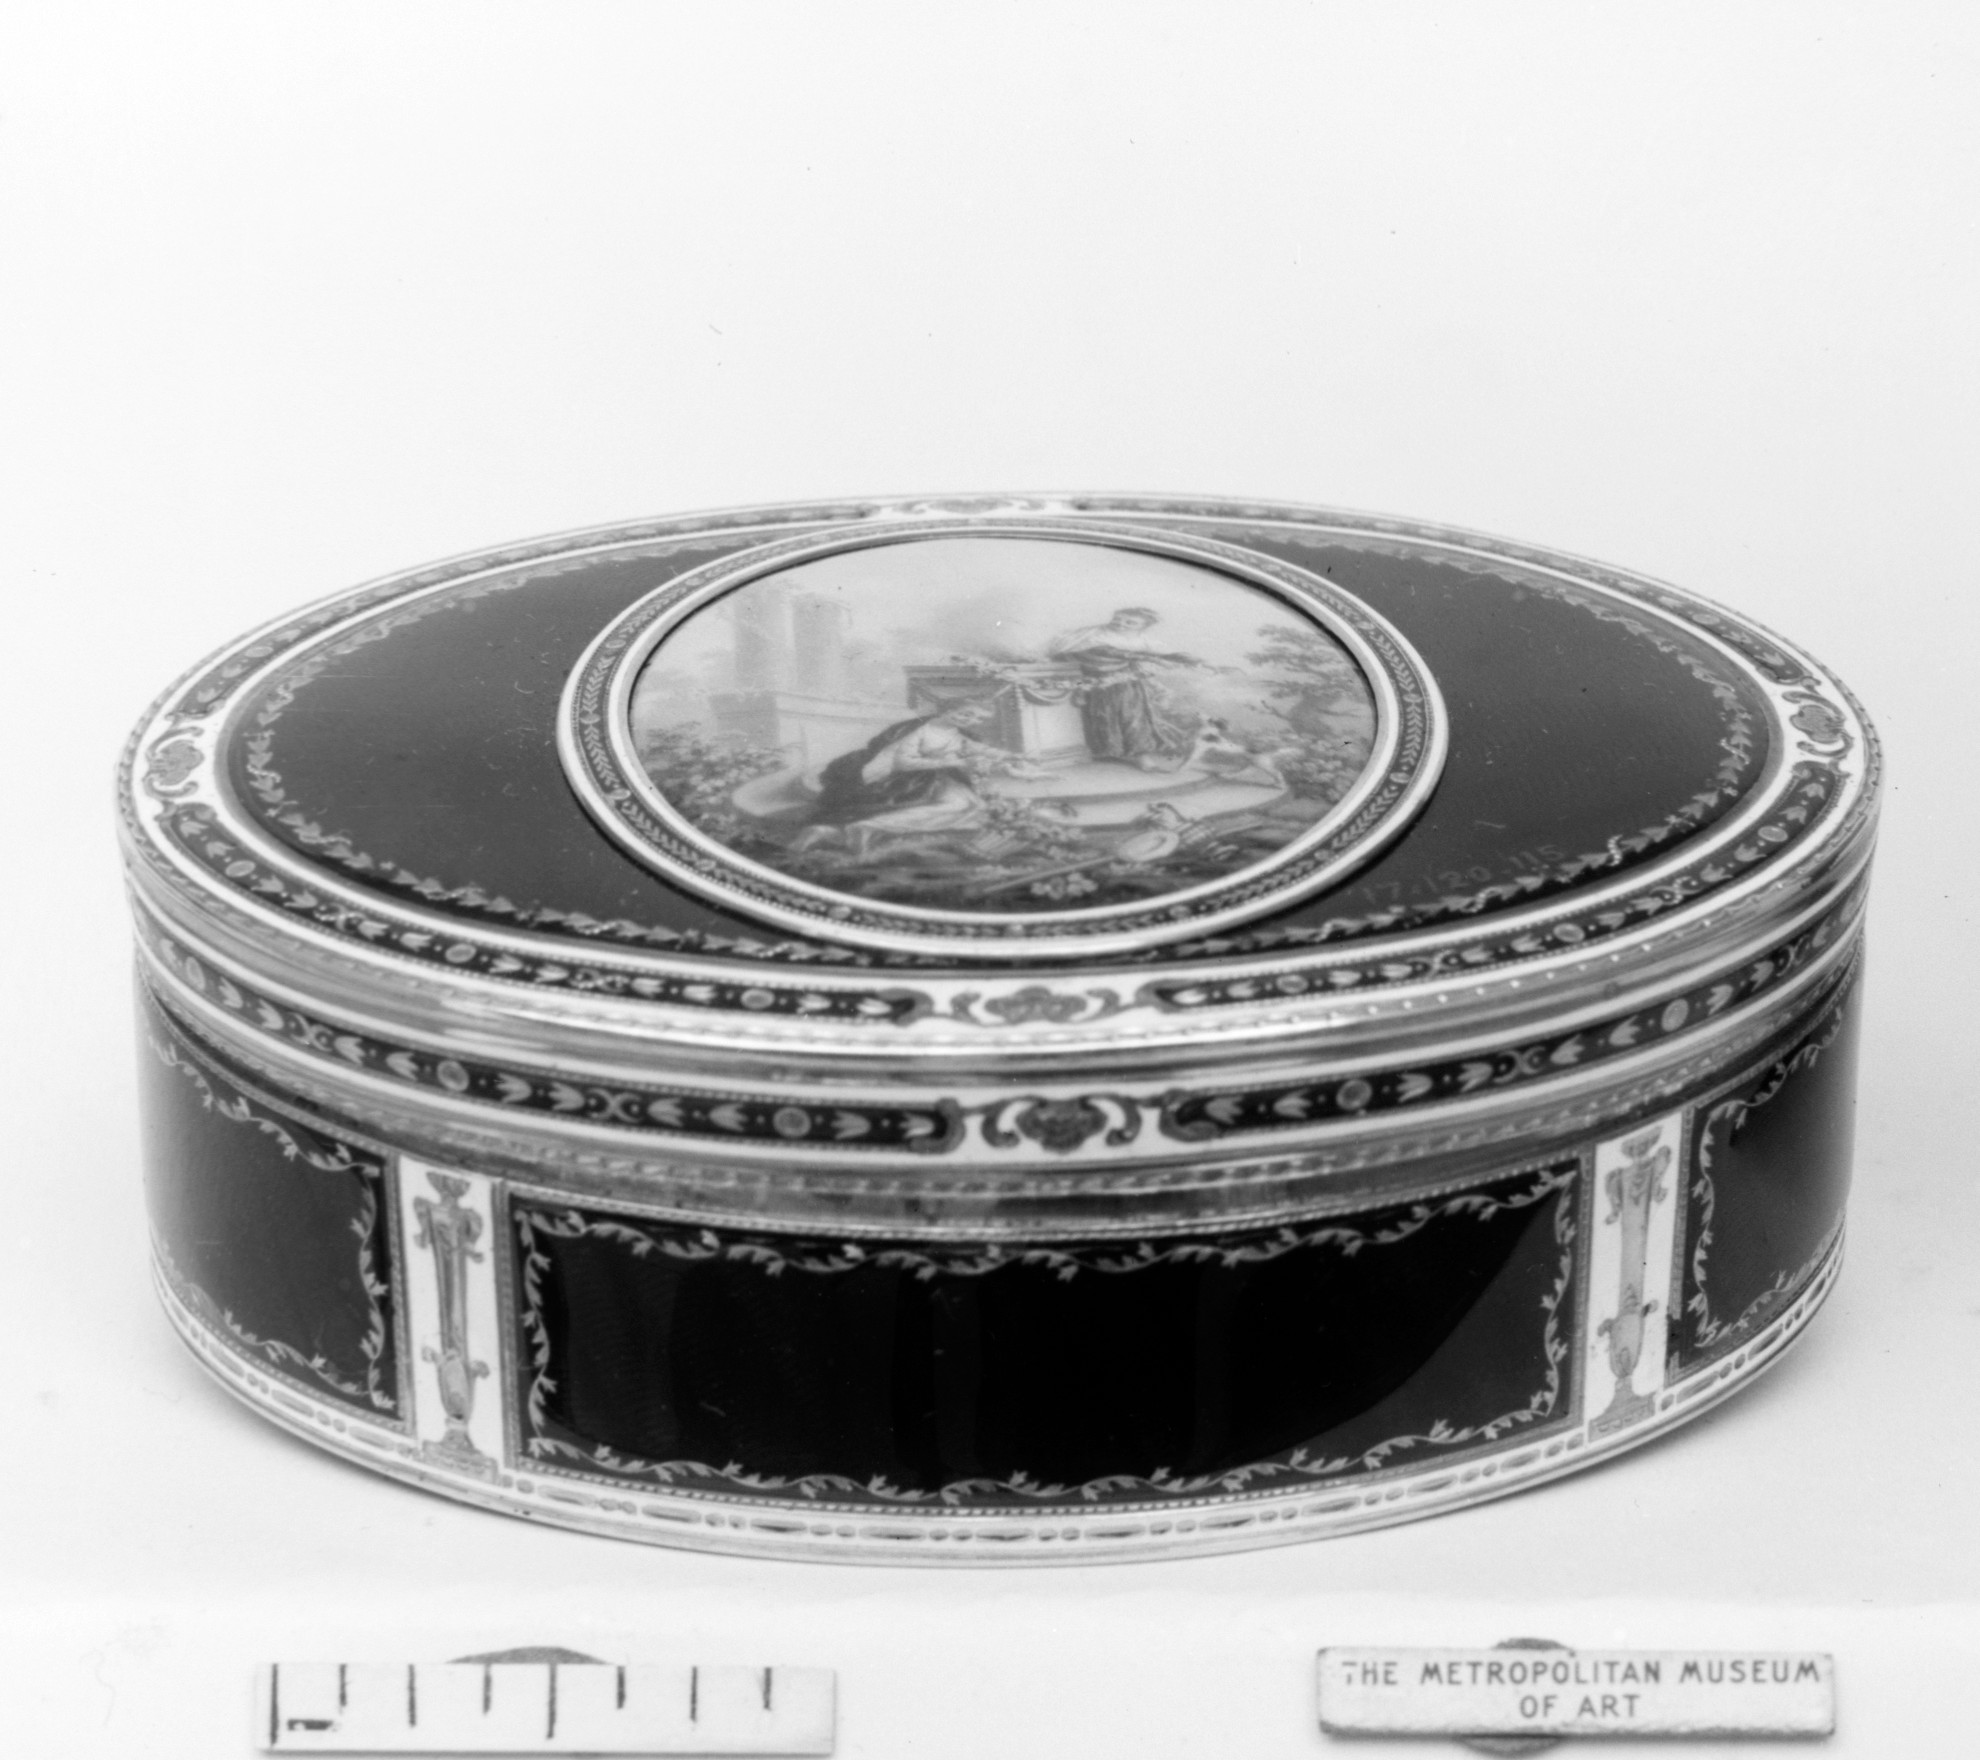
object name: snuffbox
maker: i.g.r. (possibly jean-georges reymond)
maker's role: maker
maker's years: 1753-1813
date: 1810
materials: enamel, gold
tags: human figures